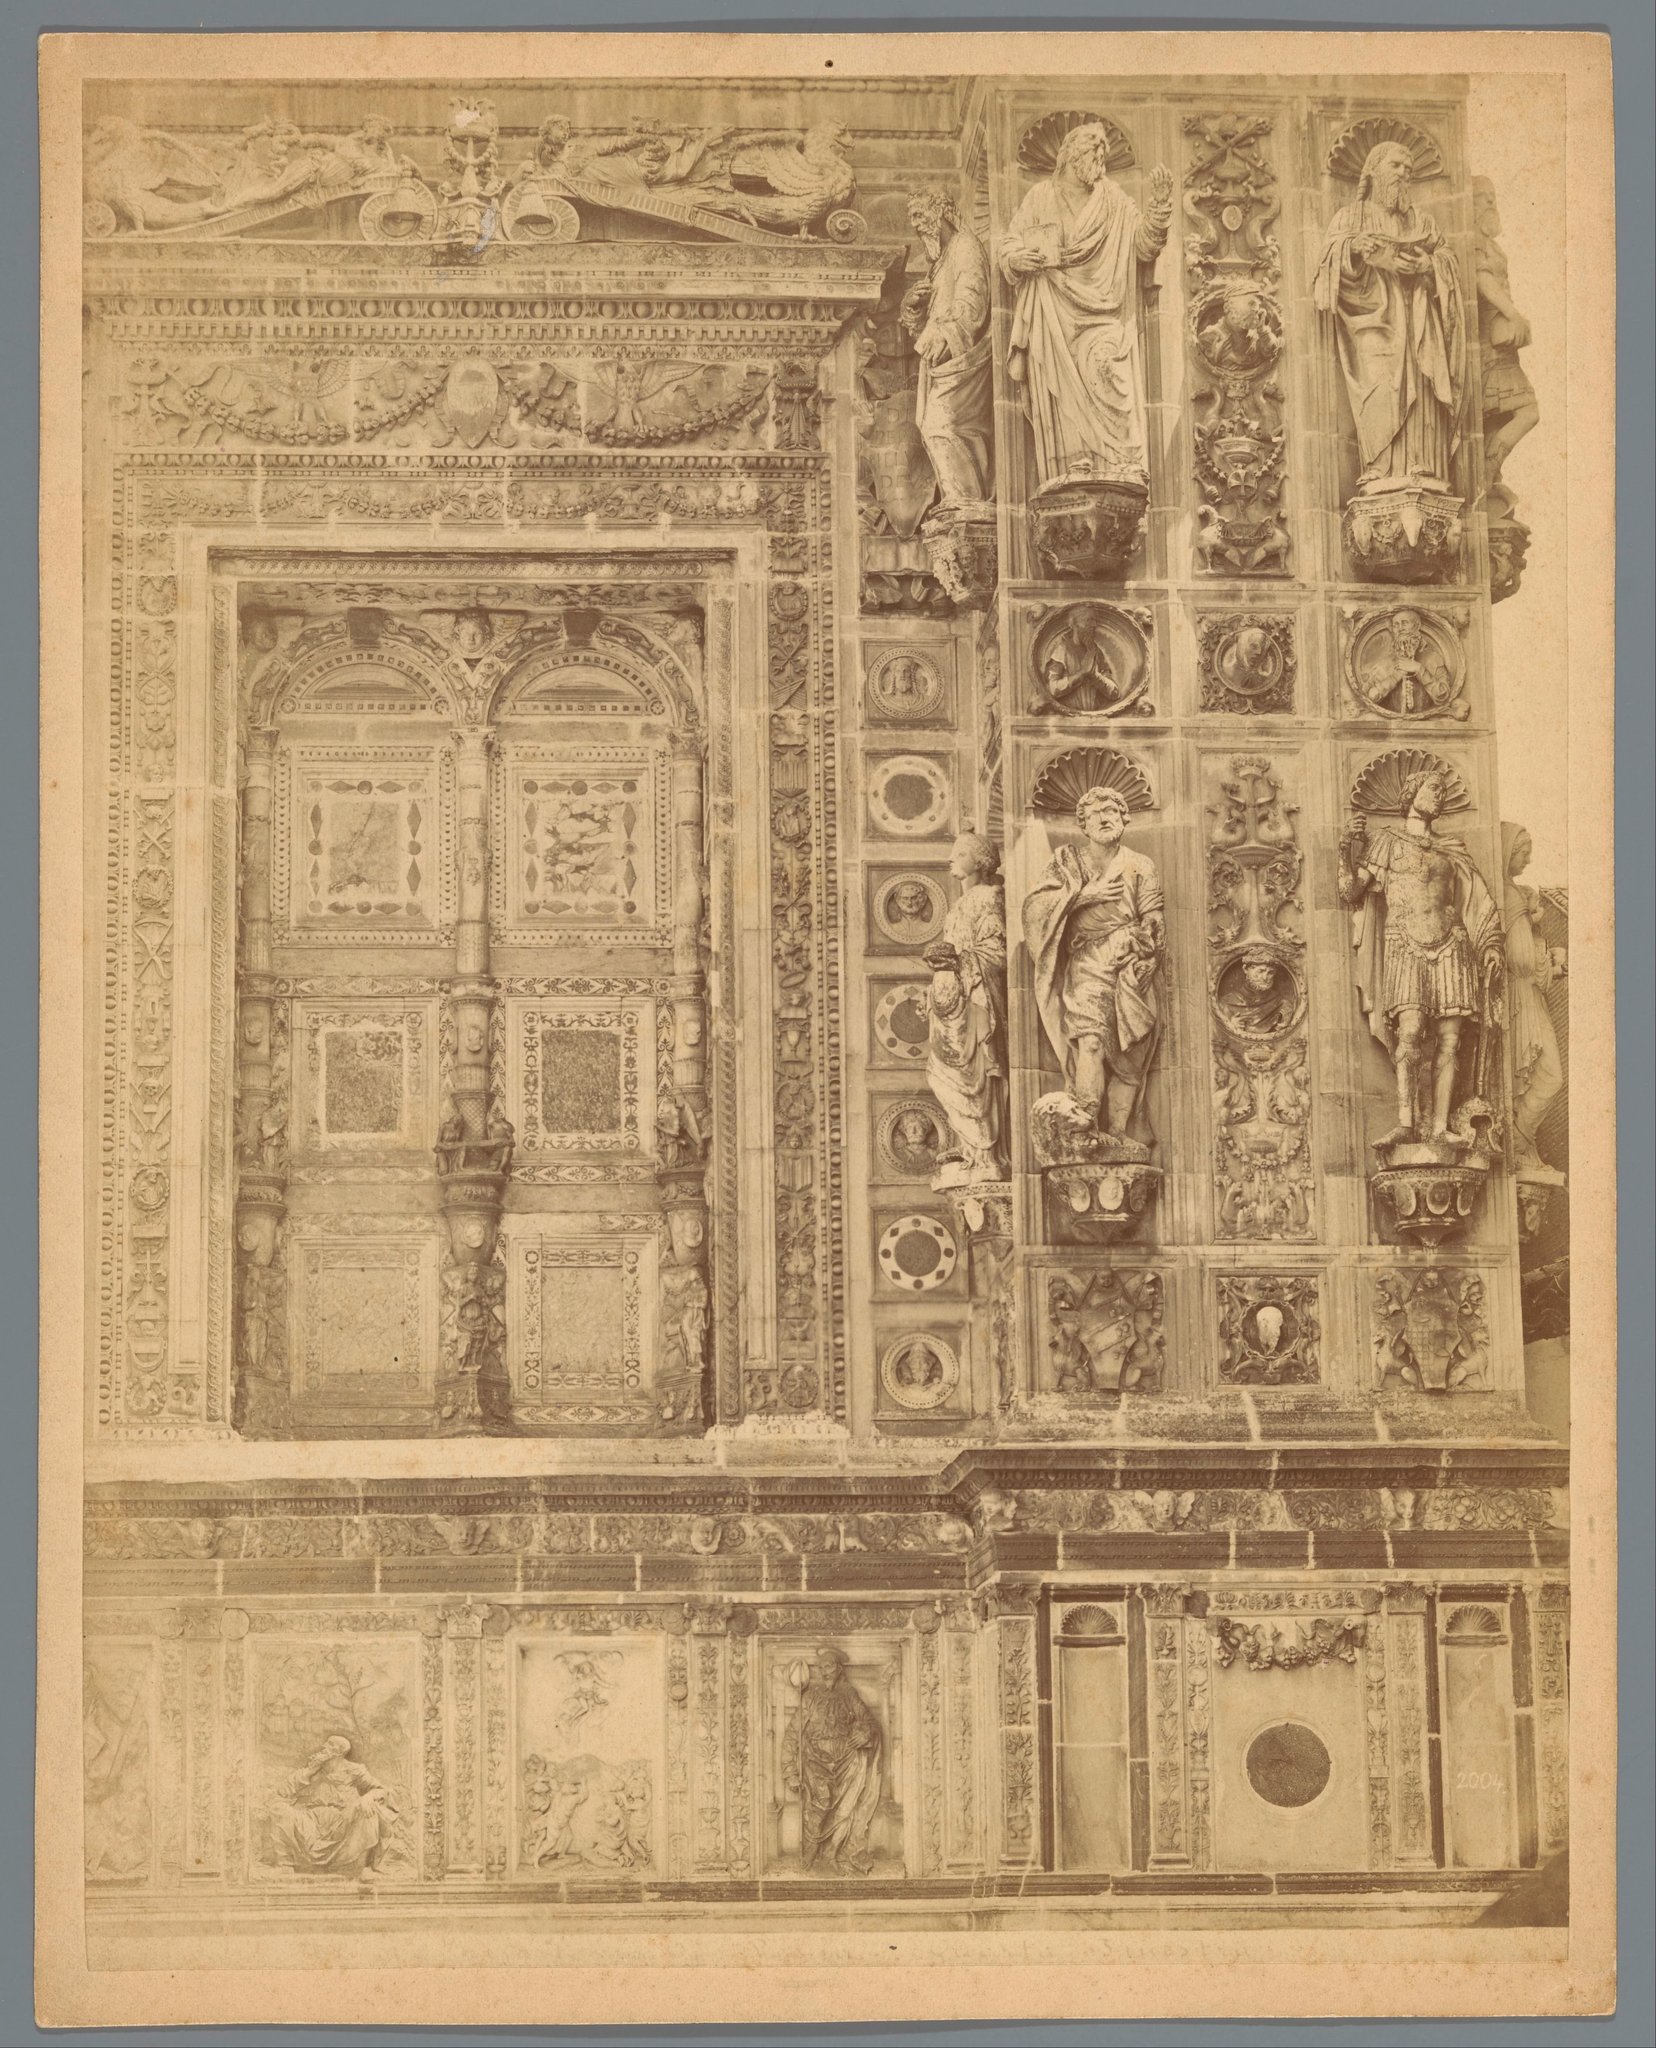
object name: photograph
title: Deel van de gevel van een kerk (vermoedelijk) in Italië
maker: Anonymous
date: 1875-1900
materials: cardboard, photographic support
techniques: albumen print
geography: italy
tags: parts of church exterior and annexes: façade, sculpture, sculpture (+ relief ~ sculpture), italy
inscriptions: number: ‘2004.’